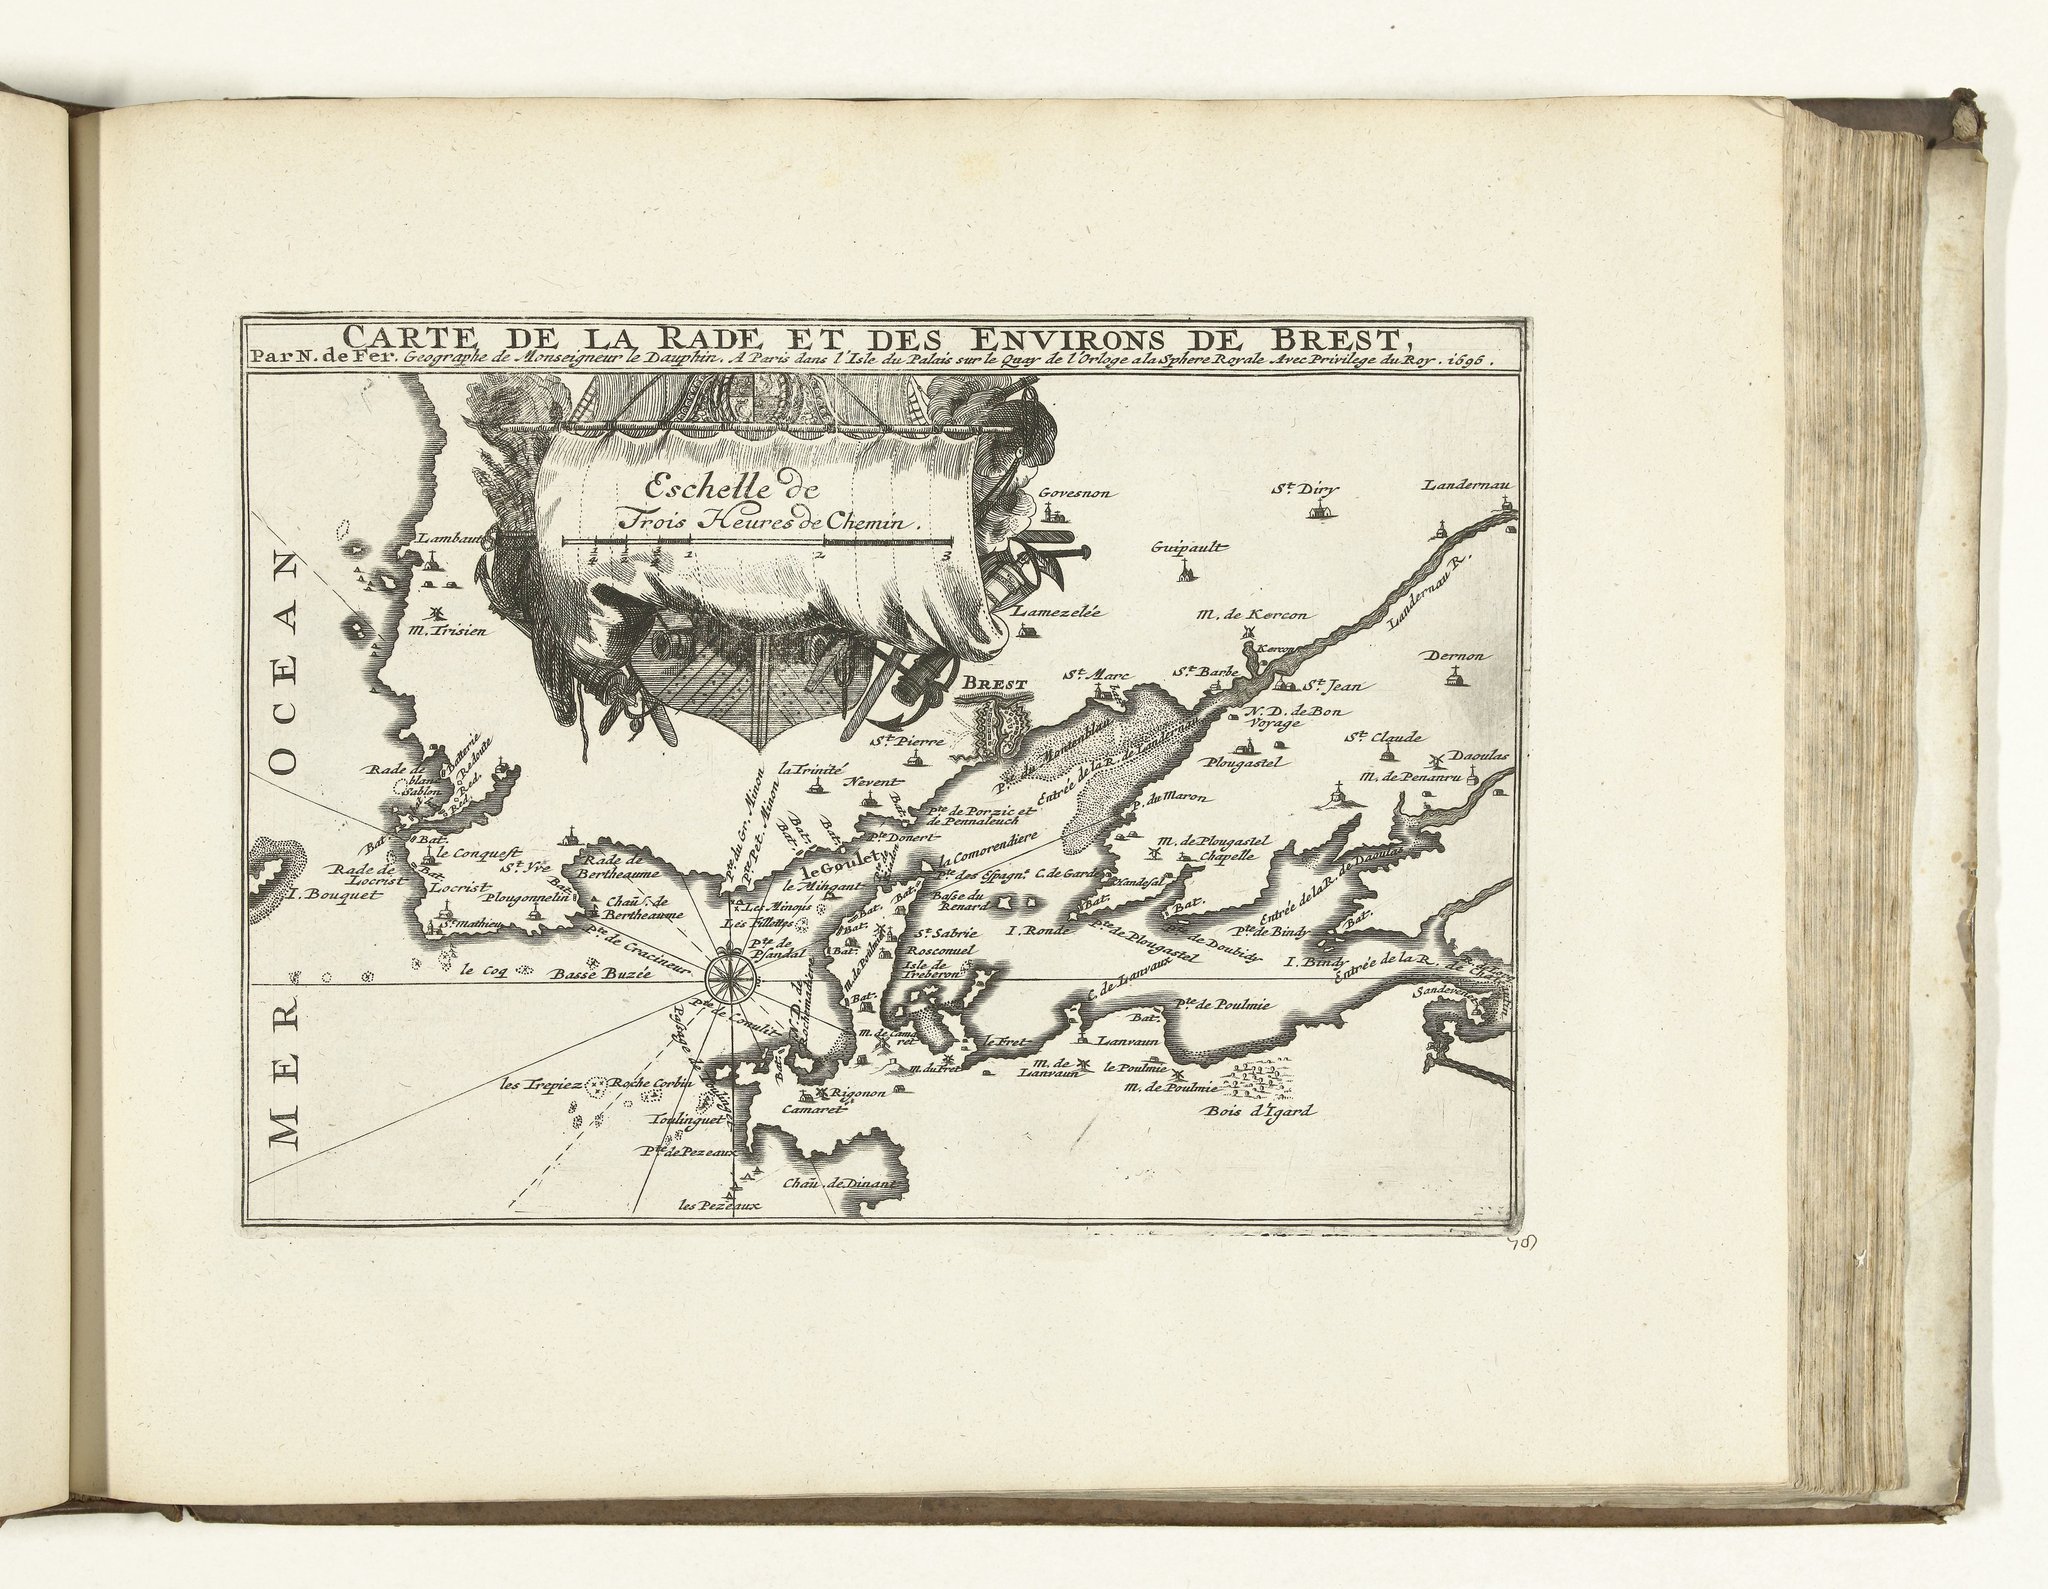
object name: print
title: Kaart van de kust bij Brest, 1726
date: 1726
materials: paper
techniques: engraving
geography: northern netherlands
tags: maps of separate countries or regions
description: Kaart van de kust bij de Franse stad Brest. Bovenaan een cartouche in de vorm van het zeil van een Frans oorlogsschip. Plaat nr. 78 in deel IV van het prentwerk: Les Forces de l'Europe, Asie, Afrique et Amerique ... Comme aussi les Cartes des Côtes de France et d'Espagne uit 1726, dit eerste deel met 238 met de hand genummerde platen van vermaarde sterke steden en vestingen in het kader van de Spaanse Successieoorlog 1701-1713. Voor het merendeel zijn deze platen gekopieerd naar de anonieme Franse platen van vermaarde sterke steden en vestingen: in Les forces de l'Europe en in: Le theatre de la guerre, dans les Pays-Bas, beide oorspronkelijk uitgegeven door Nicolas de Fer te Parijs (1693-1697) in het kader van de Negenjarige Oorlog. Titel en opschriften in het Frans. Rechtsonder sporen van het weggepolijste nummer: 235.